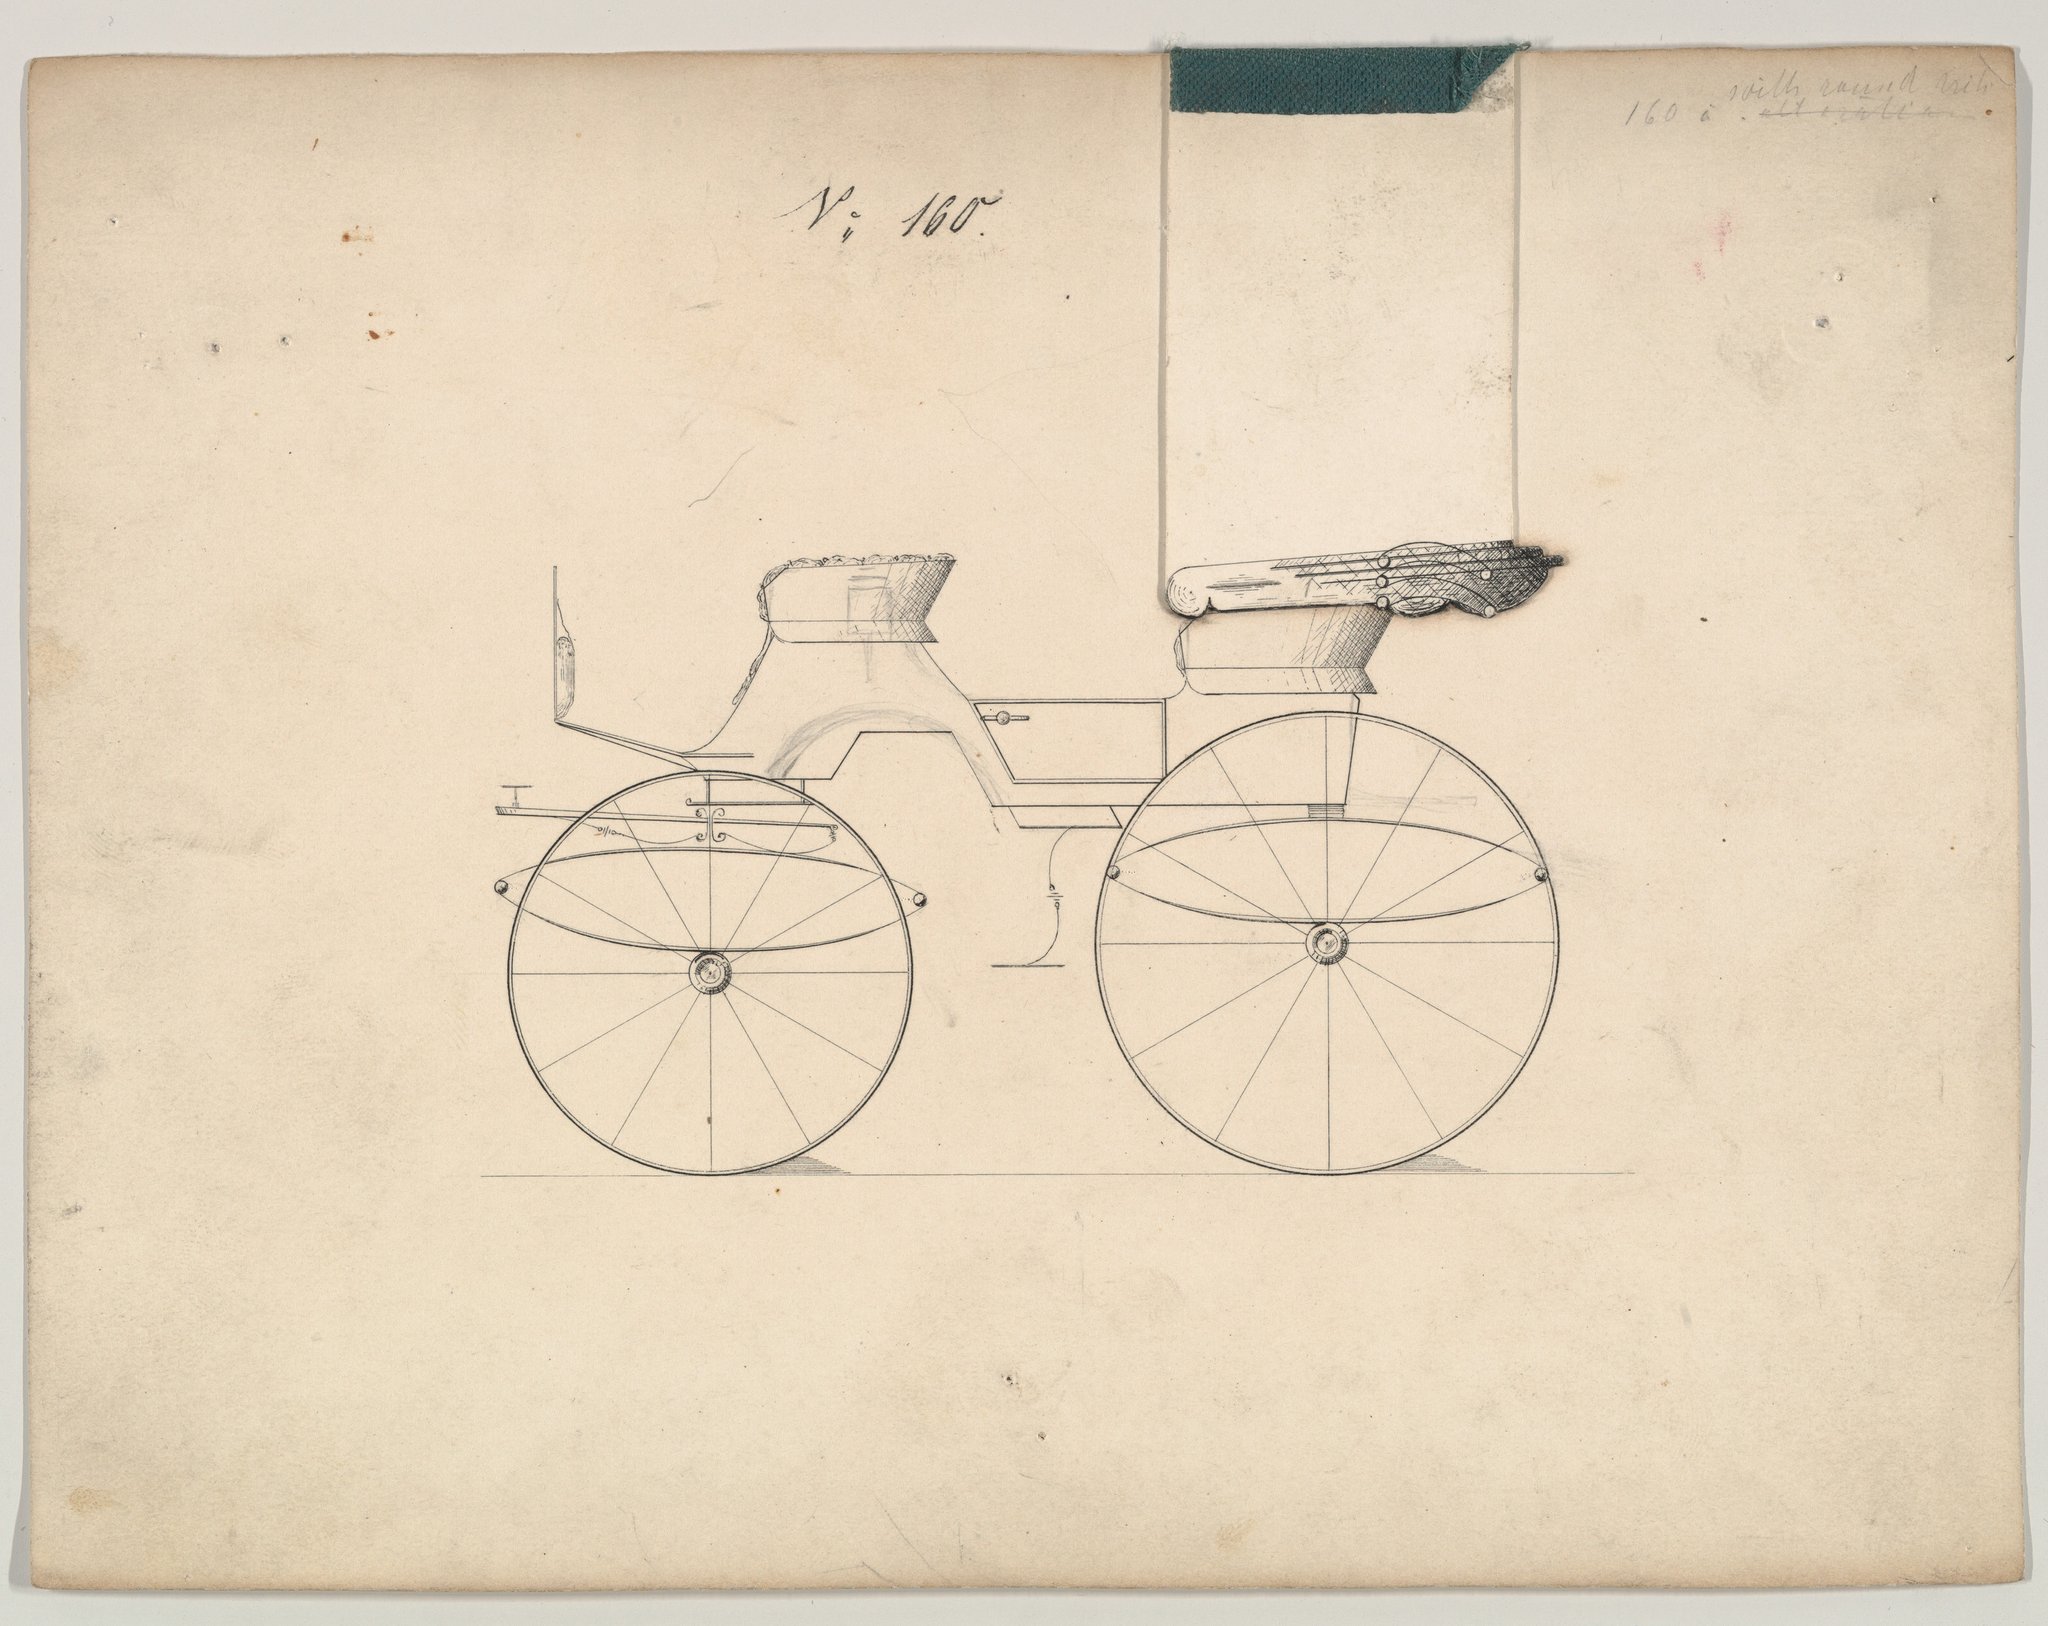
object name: drawing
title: Design for Phaeton, no. 160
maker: brewster & co.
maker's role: manufacturer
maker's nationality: american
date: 1850-1874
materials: graphite, ink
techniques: pen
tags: carriages